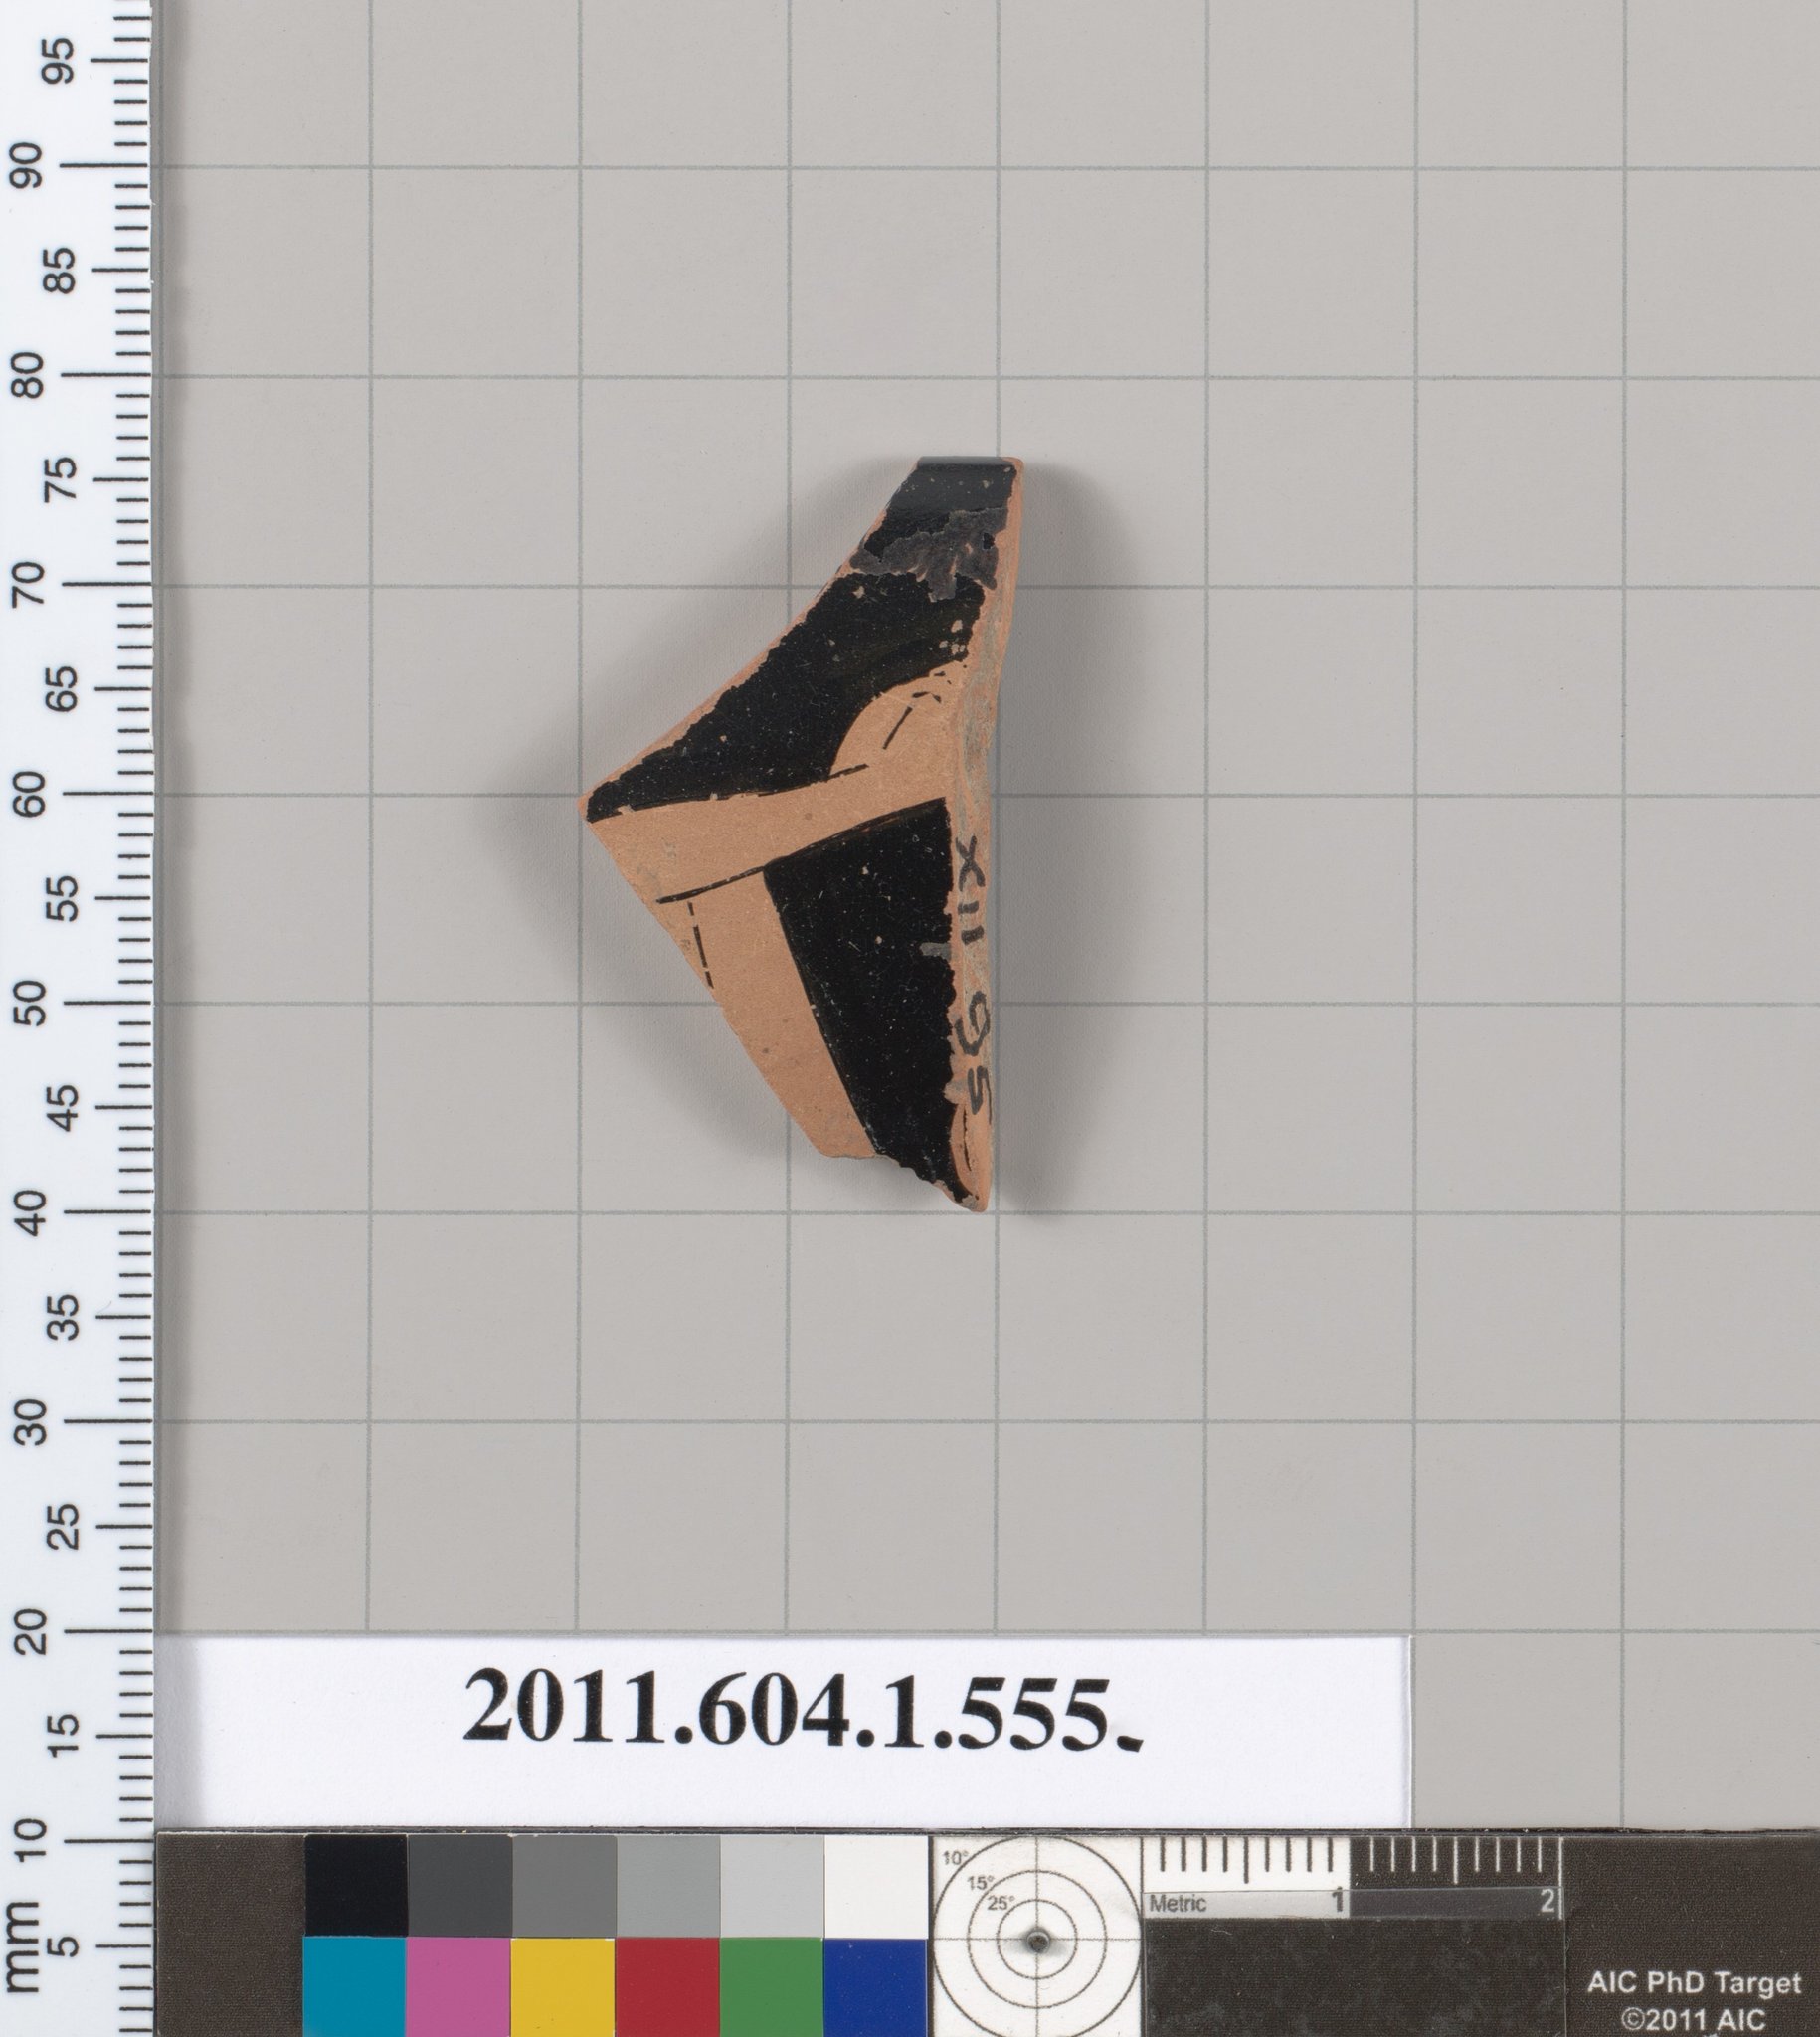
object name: kylix fragment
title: Terracotta rim fragment of a kylix (drinking cup)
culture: greek, attic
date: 480-470 BCE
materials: terracotta